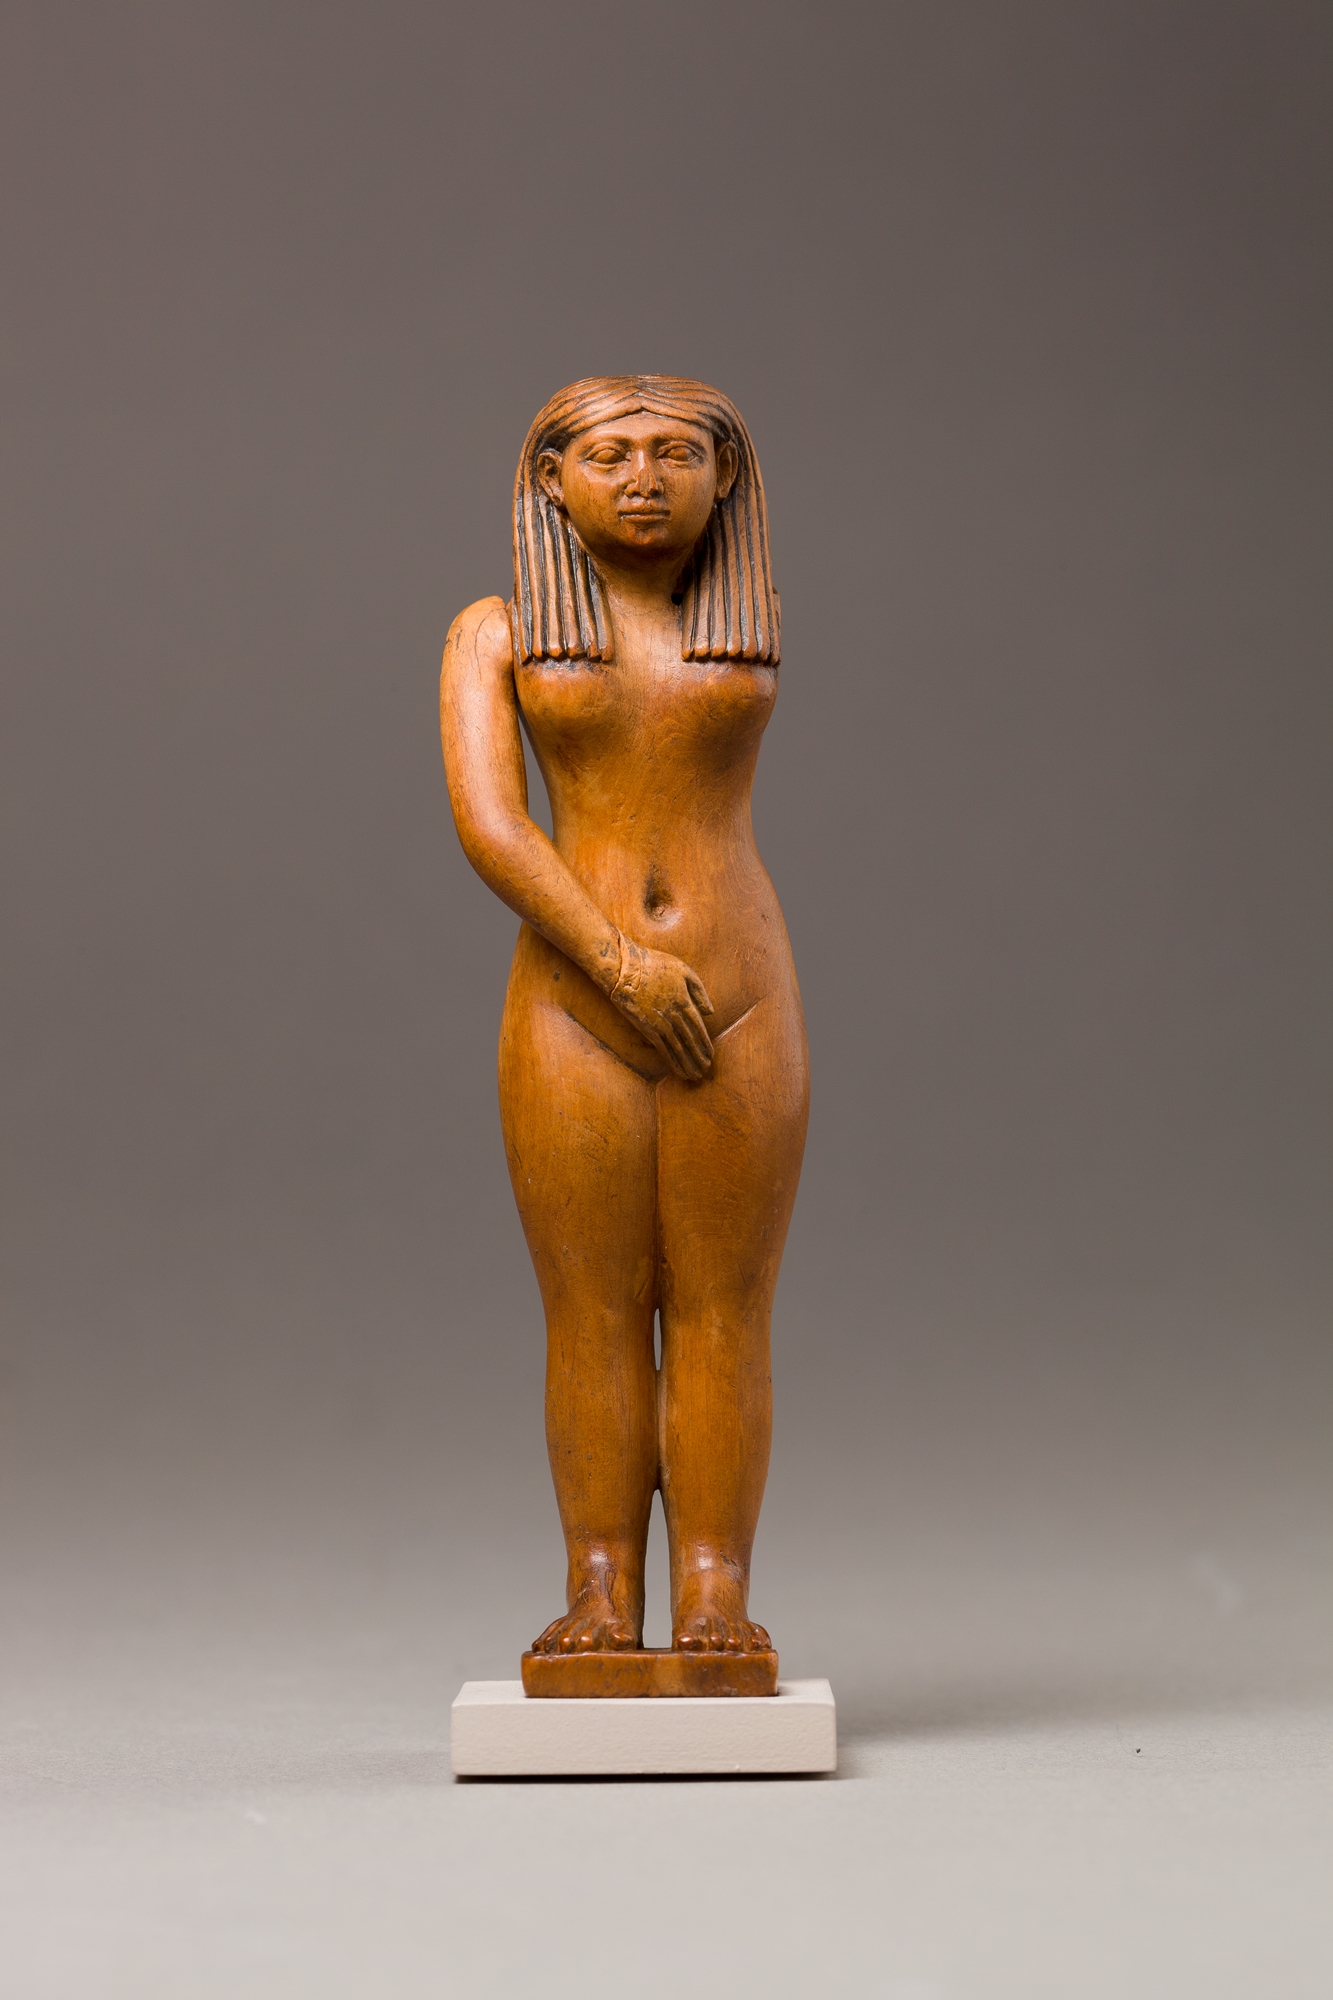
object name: statuette, female nude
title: Statuette of a nude woman with moveable arms, one missing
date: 945-664 BCE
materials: wood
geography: egypt